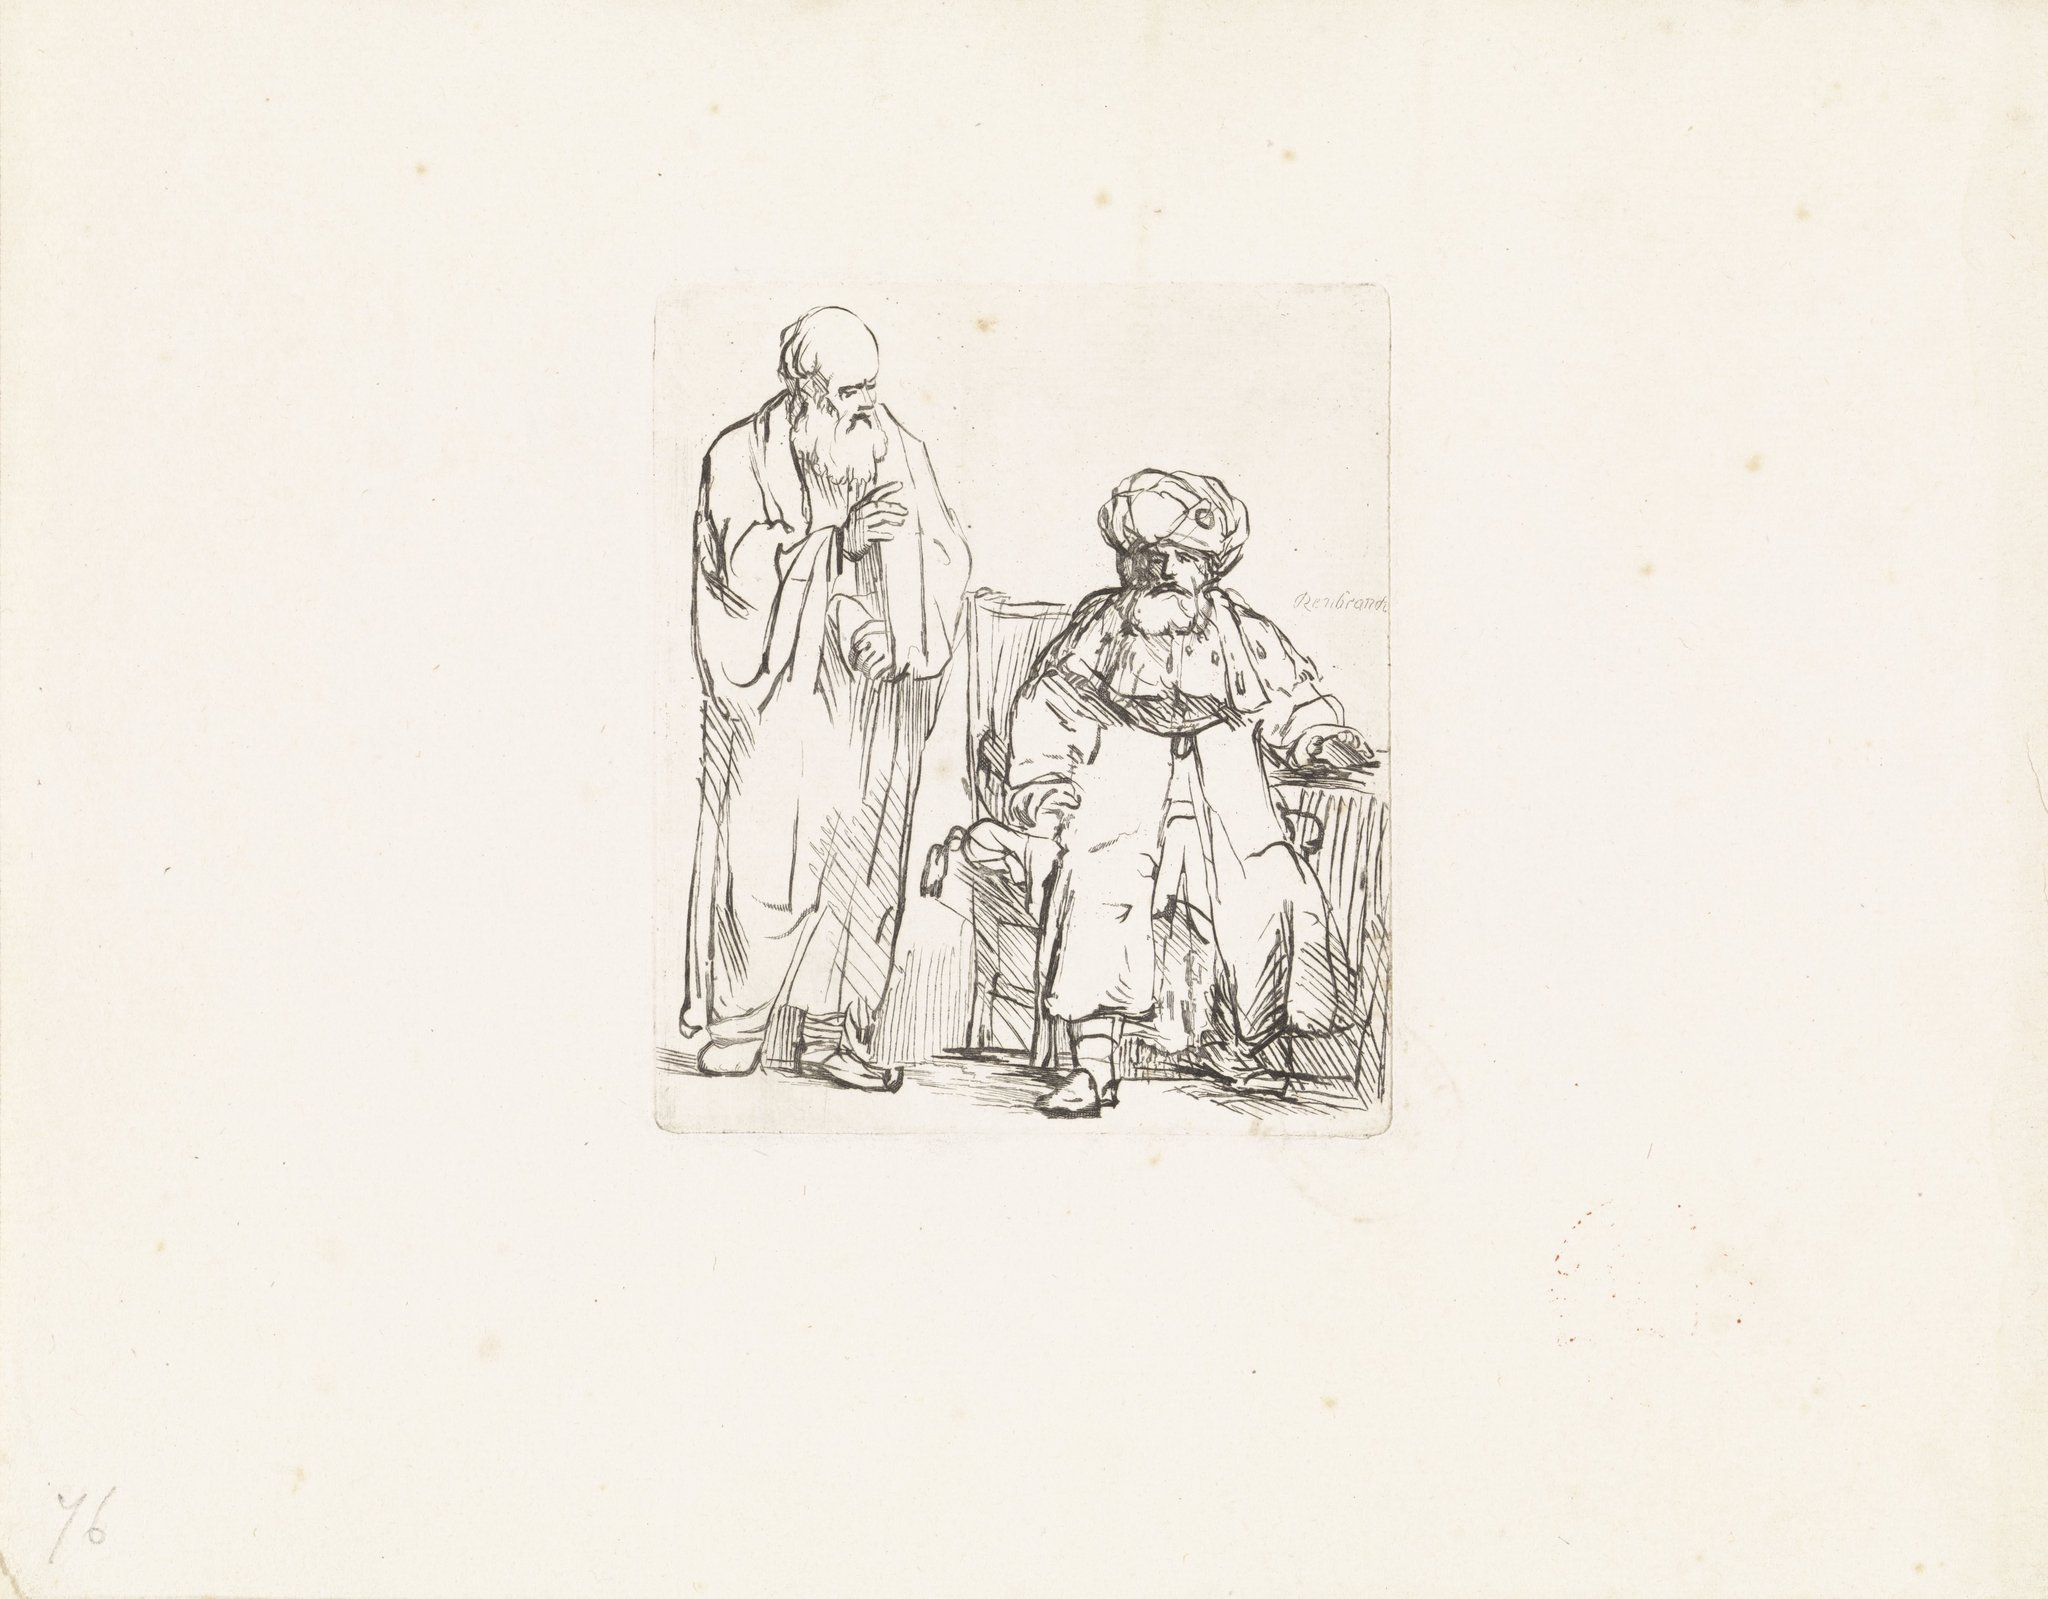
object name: print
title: Verscheide gedagten in het koper gebragt naar de origenelen teekeningen en schetschen van Rembrandt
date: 1696-1727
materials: paper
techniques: engraving, etching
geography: amsterdam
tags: david rebuked by nathan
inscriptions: collector's mark: Lugt 240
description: De profeet Natan staat naast David en spreekt hem toe. Hij wijst de koning op de zonden die hij beging door Uria te doden en bij Batseba een kind te verwekken.